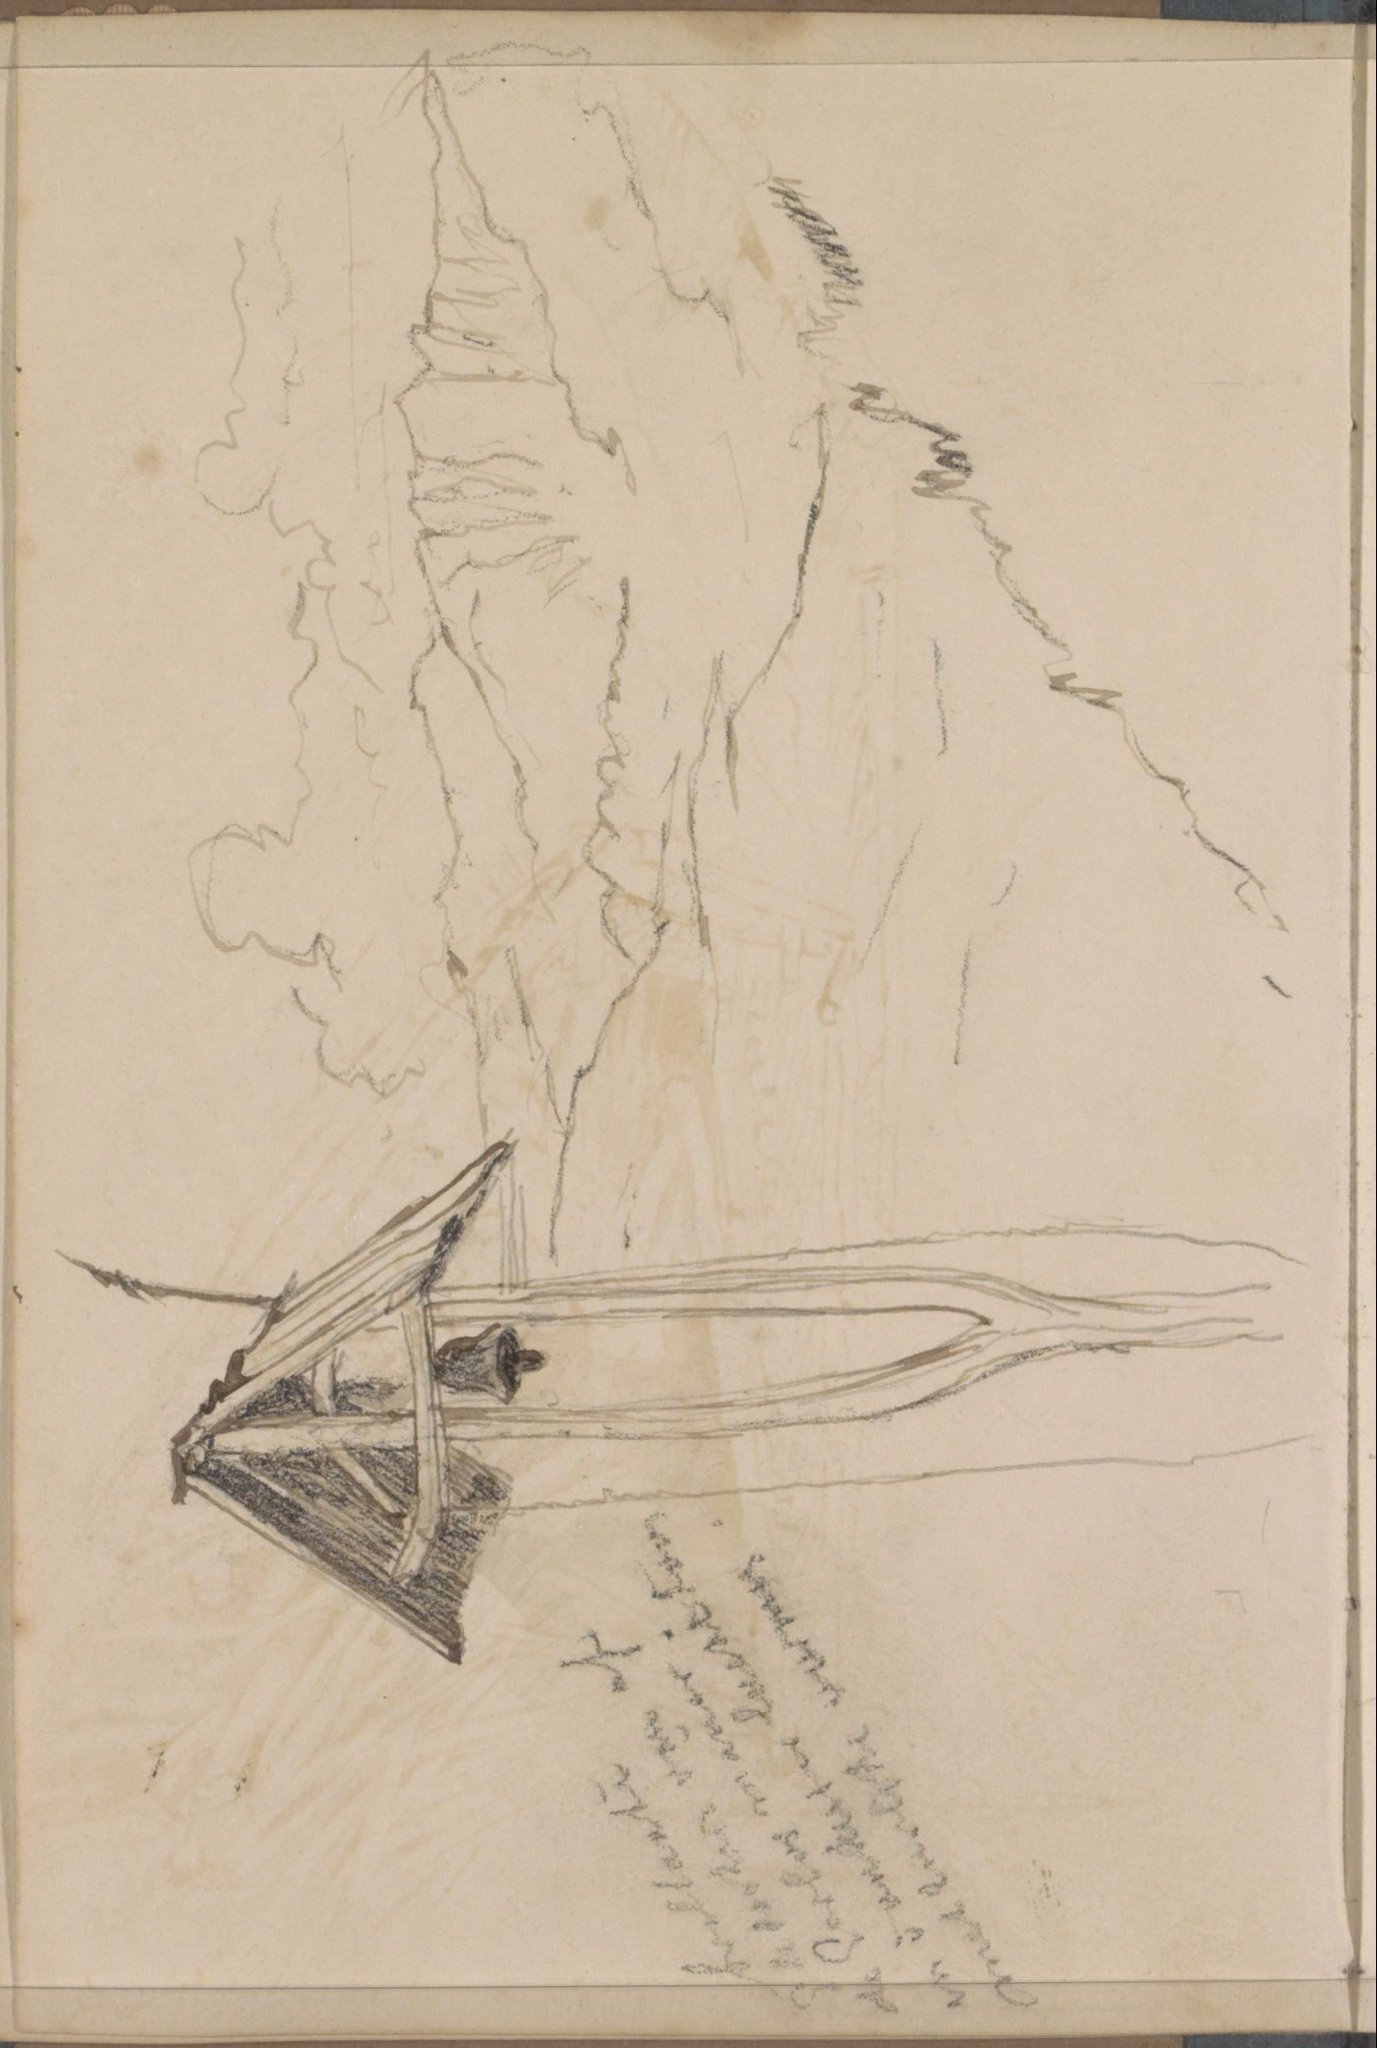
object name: sketchbook leaf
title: Berglandschap met een houten beltoren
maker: johannes tavenraat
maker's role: draughtsman, painter, print maker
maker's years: 1809-1881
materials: ink, paper, pencil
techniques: pen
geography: gerlos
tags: carillon, chimes - cc - out of doors, mountains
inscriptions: kleurnotitie, handgeschreven in potlood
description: Blad 11 verso uit een schetsboek met 47 bladen.